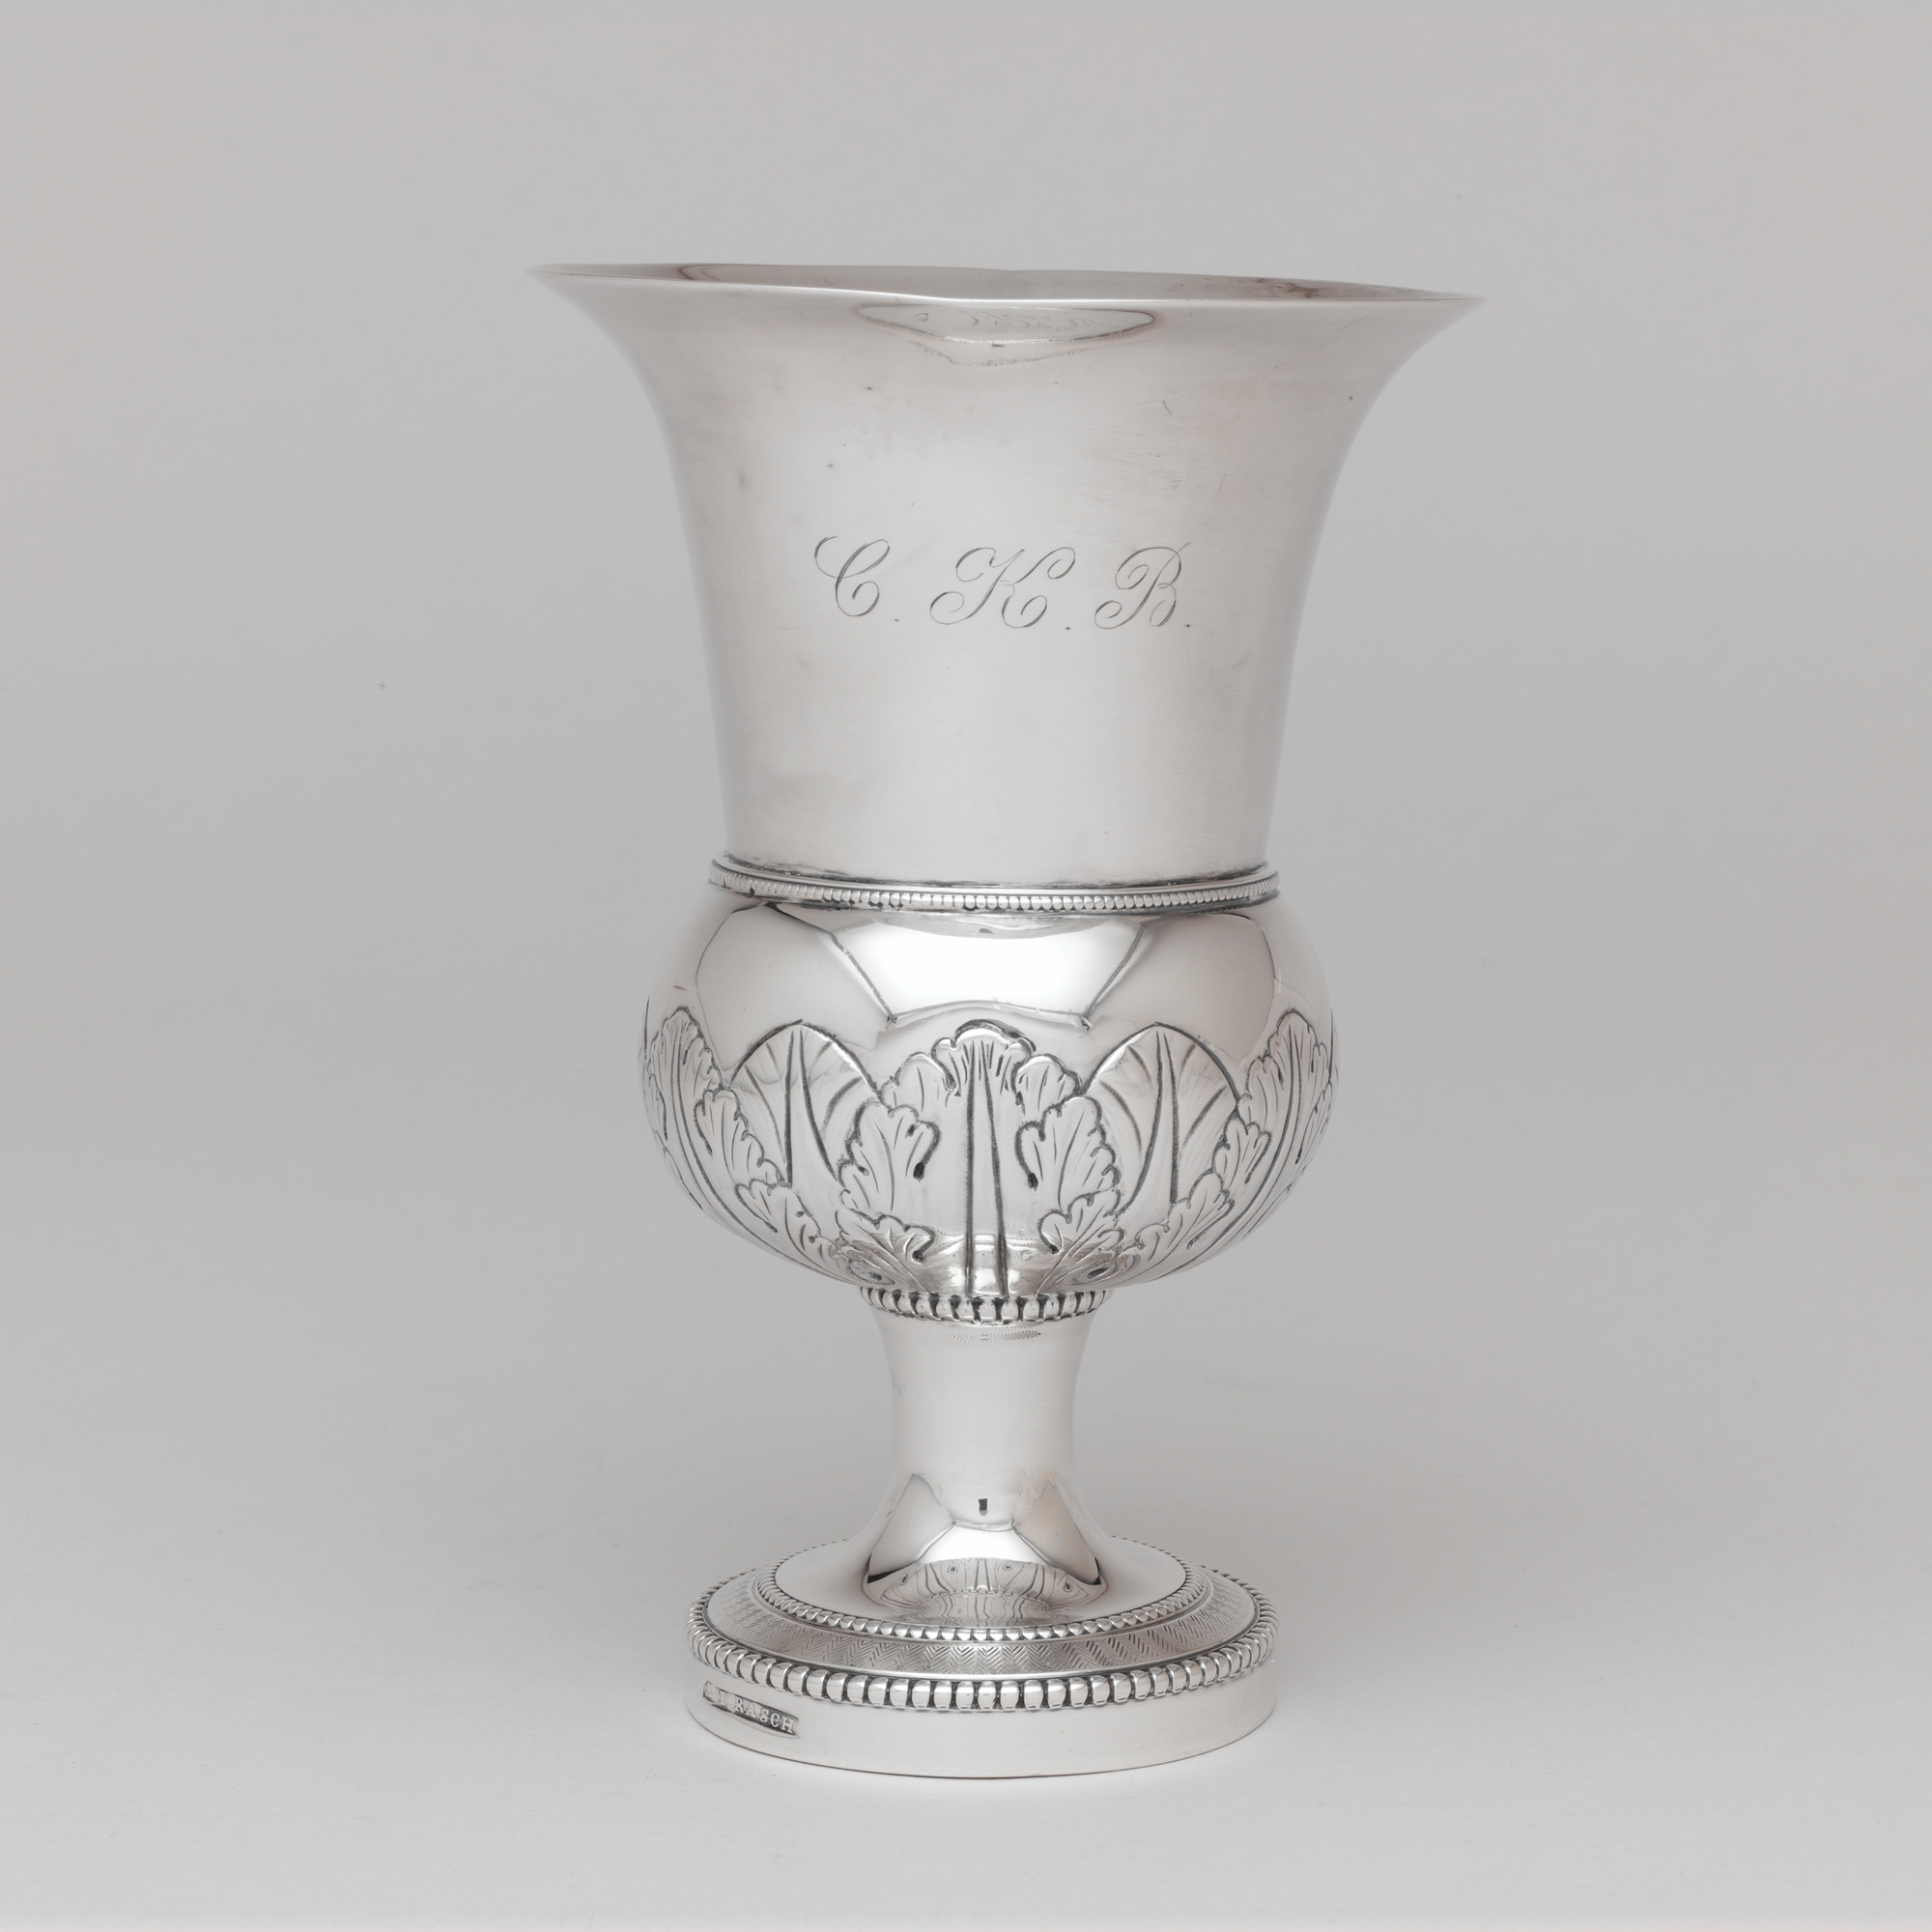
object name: goblet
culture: american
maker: anthony rasch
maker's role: maker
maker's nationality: american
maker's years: 1804-1858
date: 1815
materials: silver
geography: united states